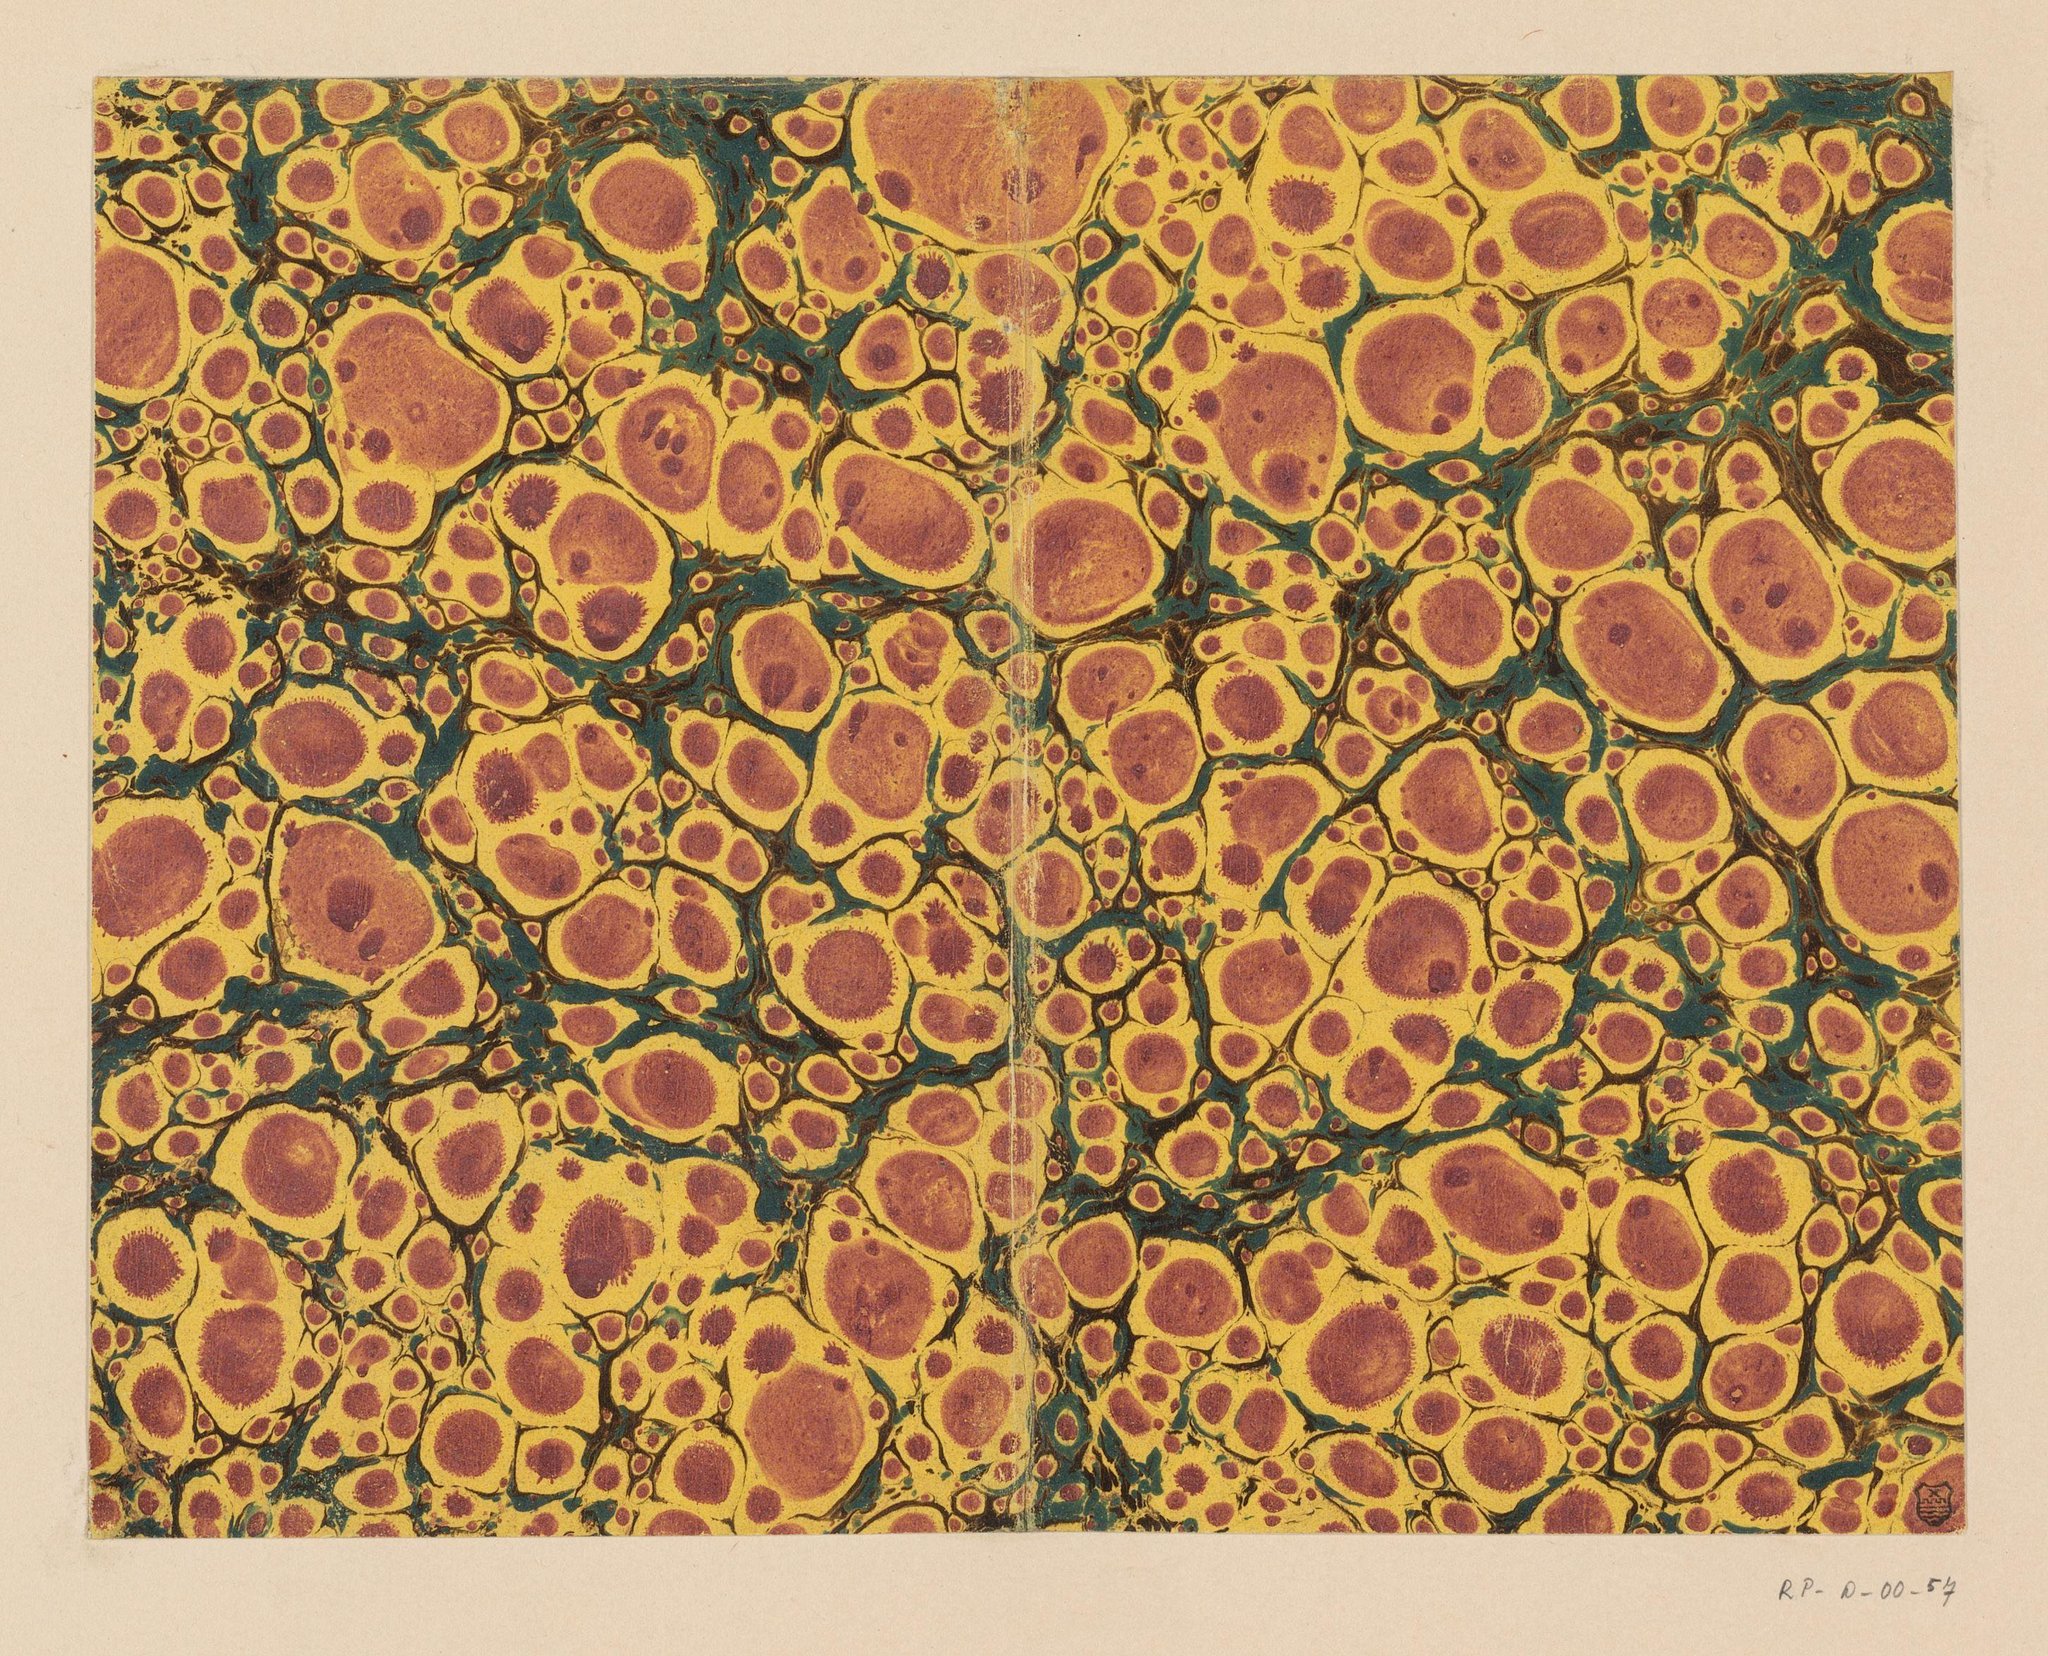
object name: marbled paper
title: Kiezelmarmer in groen, bruin, geel en rood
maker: Anonymous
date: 1700-1850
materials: paint, paper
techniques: marbling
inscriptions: collector's mark: Lugt 2760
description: Kiezelmarmer in groen, bruin, geel en rood. Gebruikt als omslag.